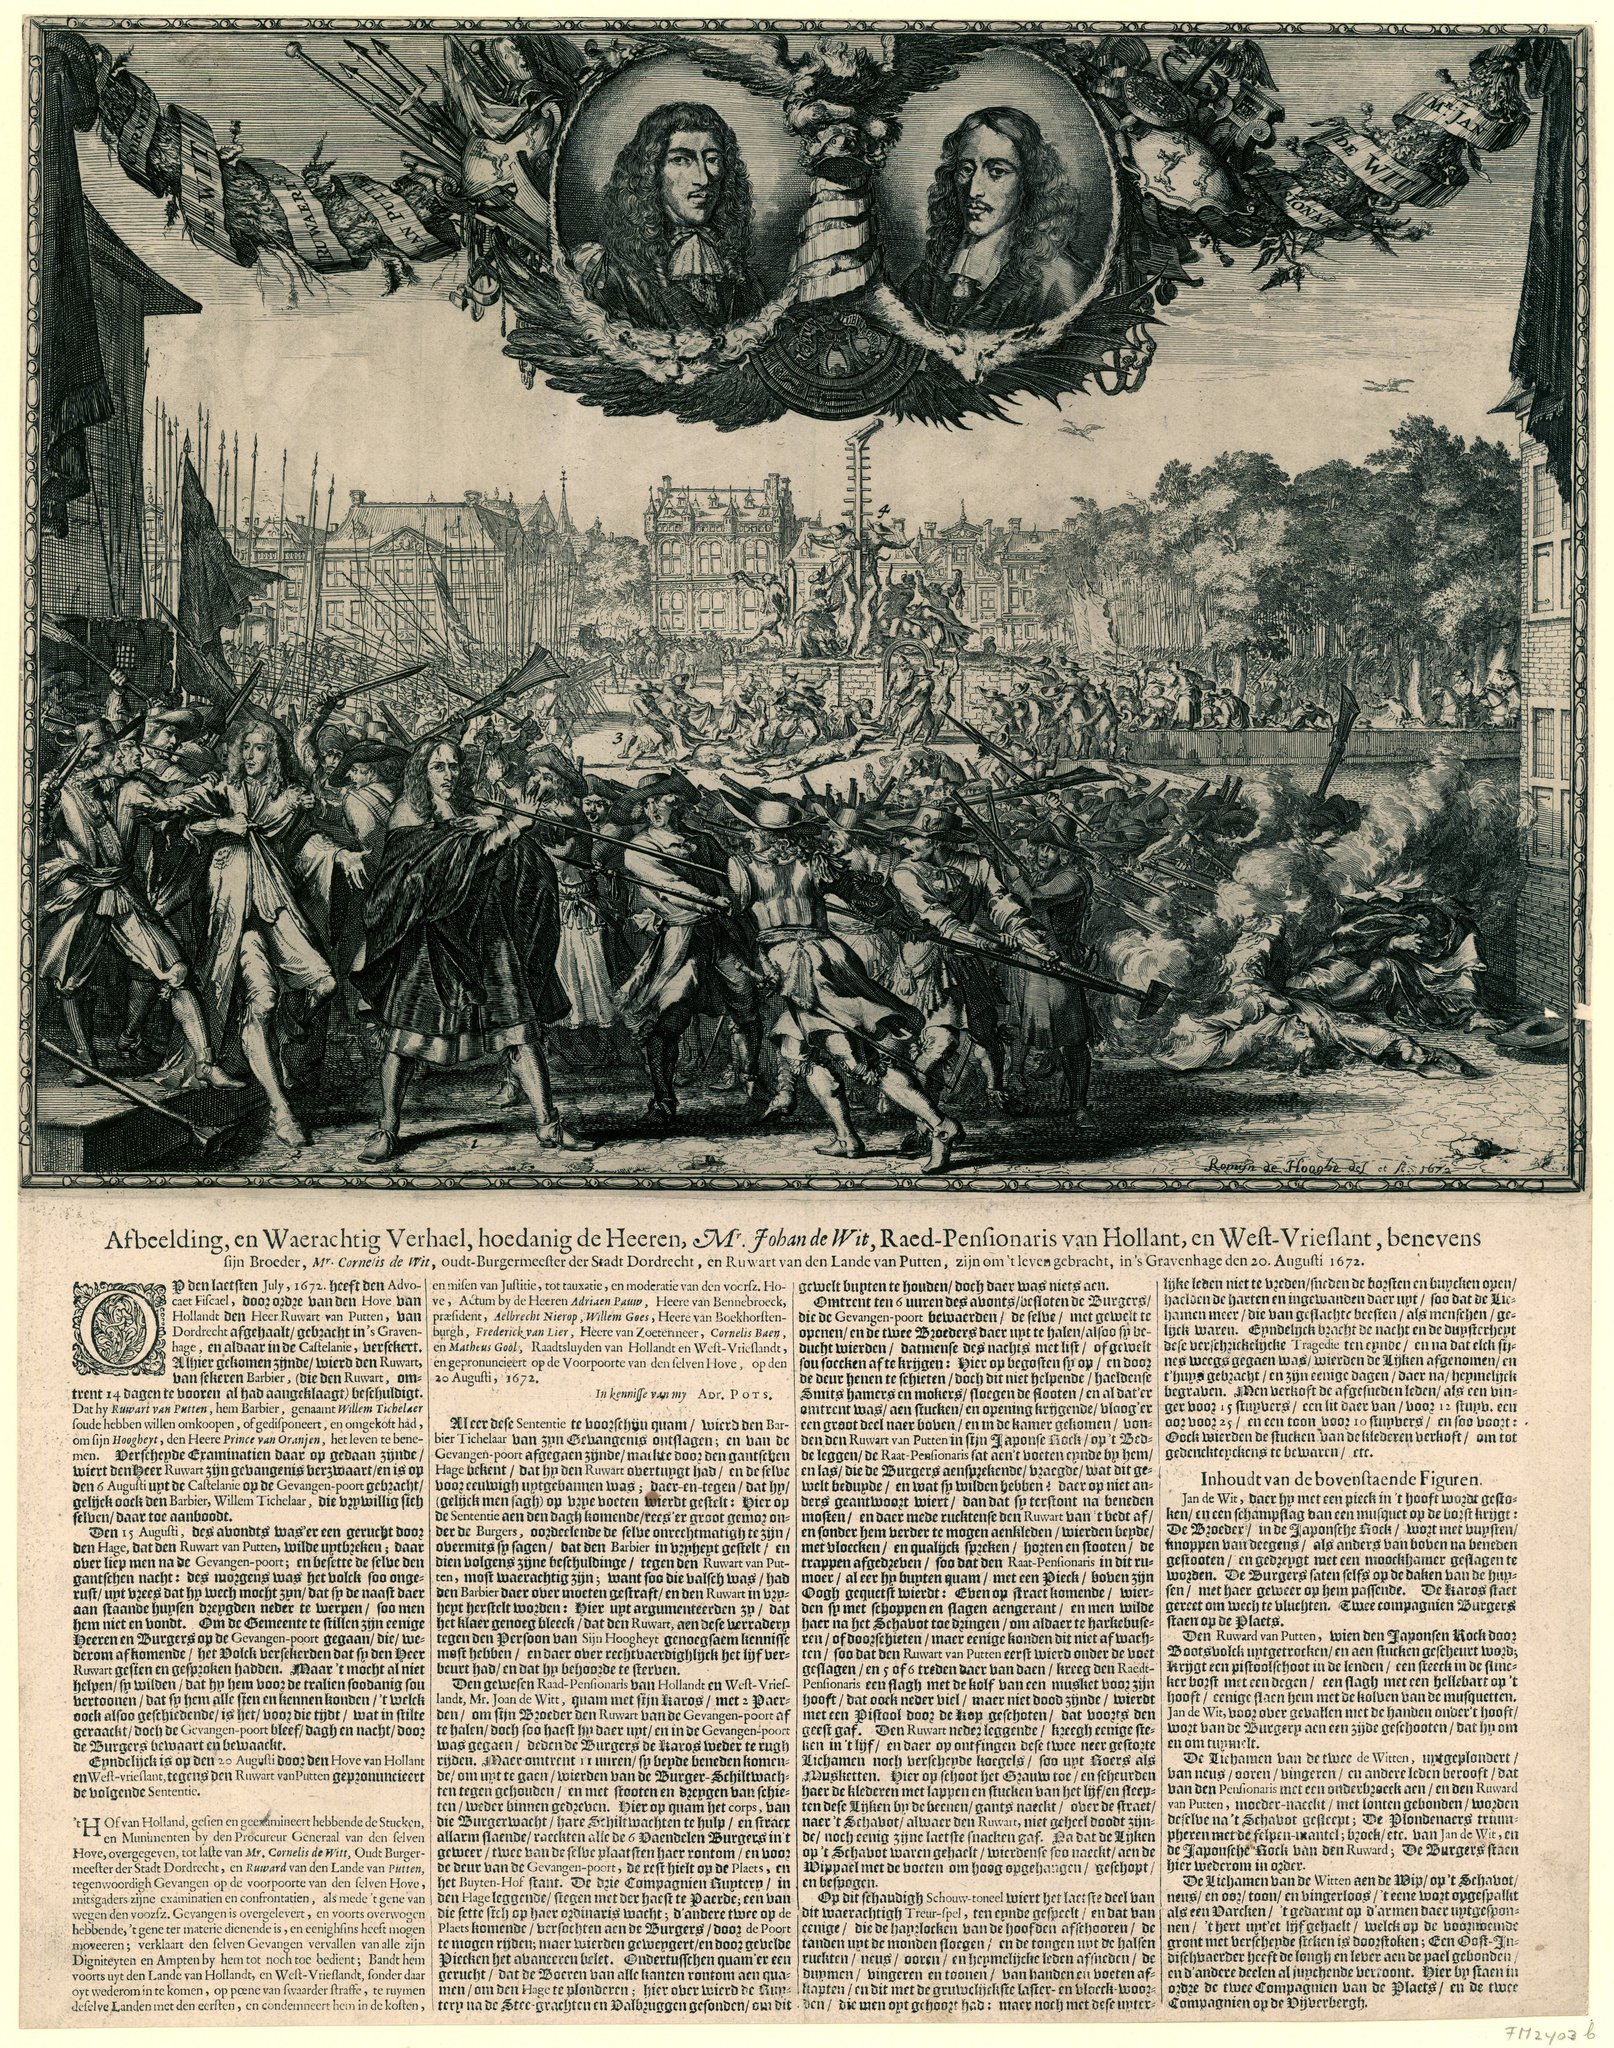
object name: print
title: Afbeelding, en Waerachtig Verhaal, hoedanig de Heeren, Mr. Johan de Wit, Raed-Pensionaris van Hollant, en West-Vrieslant, benevens zijn Broeder, Mr. Cornelis de Wit, oudt-Burgermeester der Stadt Dordrecht, en Ruwart van den Lande van Putten, zijn om't leven gebracht, in 's Gravenhage, den 20. Augusti 1672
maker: romeyn de hooghe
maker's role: draughtsman, goldsmith, painter, print maker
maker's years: 1645-1708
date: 1672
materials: paper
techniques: engraving, etching, letterpress printing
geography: northern netherlands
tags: cornelis de witt, the hague, politician, johan de witt, lynching, attempt, political murder, violent death, being killed; being mishandled and maltreated; seeking death (+ death by lynching)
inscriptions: date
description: Prent waarin de verschillende episodes van de moord op de gebroeders De Witt tot één grote voorstelling zijn verwerkt. Bovenin de voorstelling zijn portretten van Johan en Cornelis de Witt aangebracht. Onderaan staat dezelfde beschrijving van de gebeurtenissen in 4 kolommen in het Nederlands, en een uitleg van de afbeelding, als in FM 2401b.